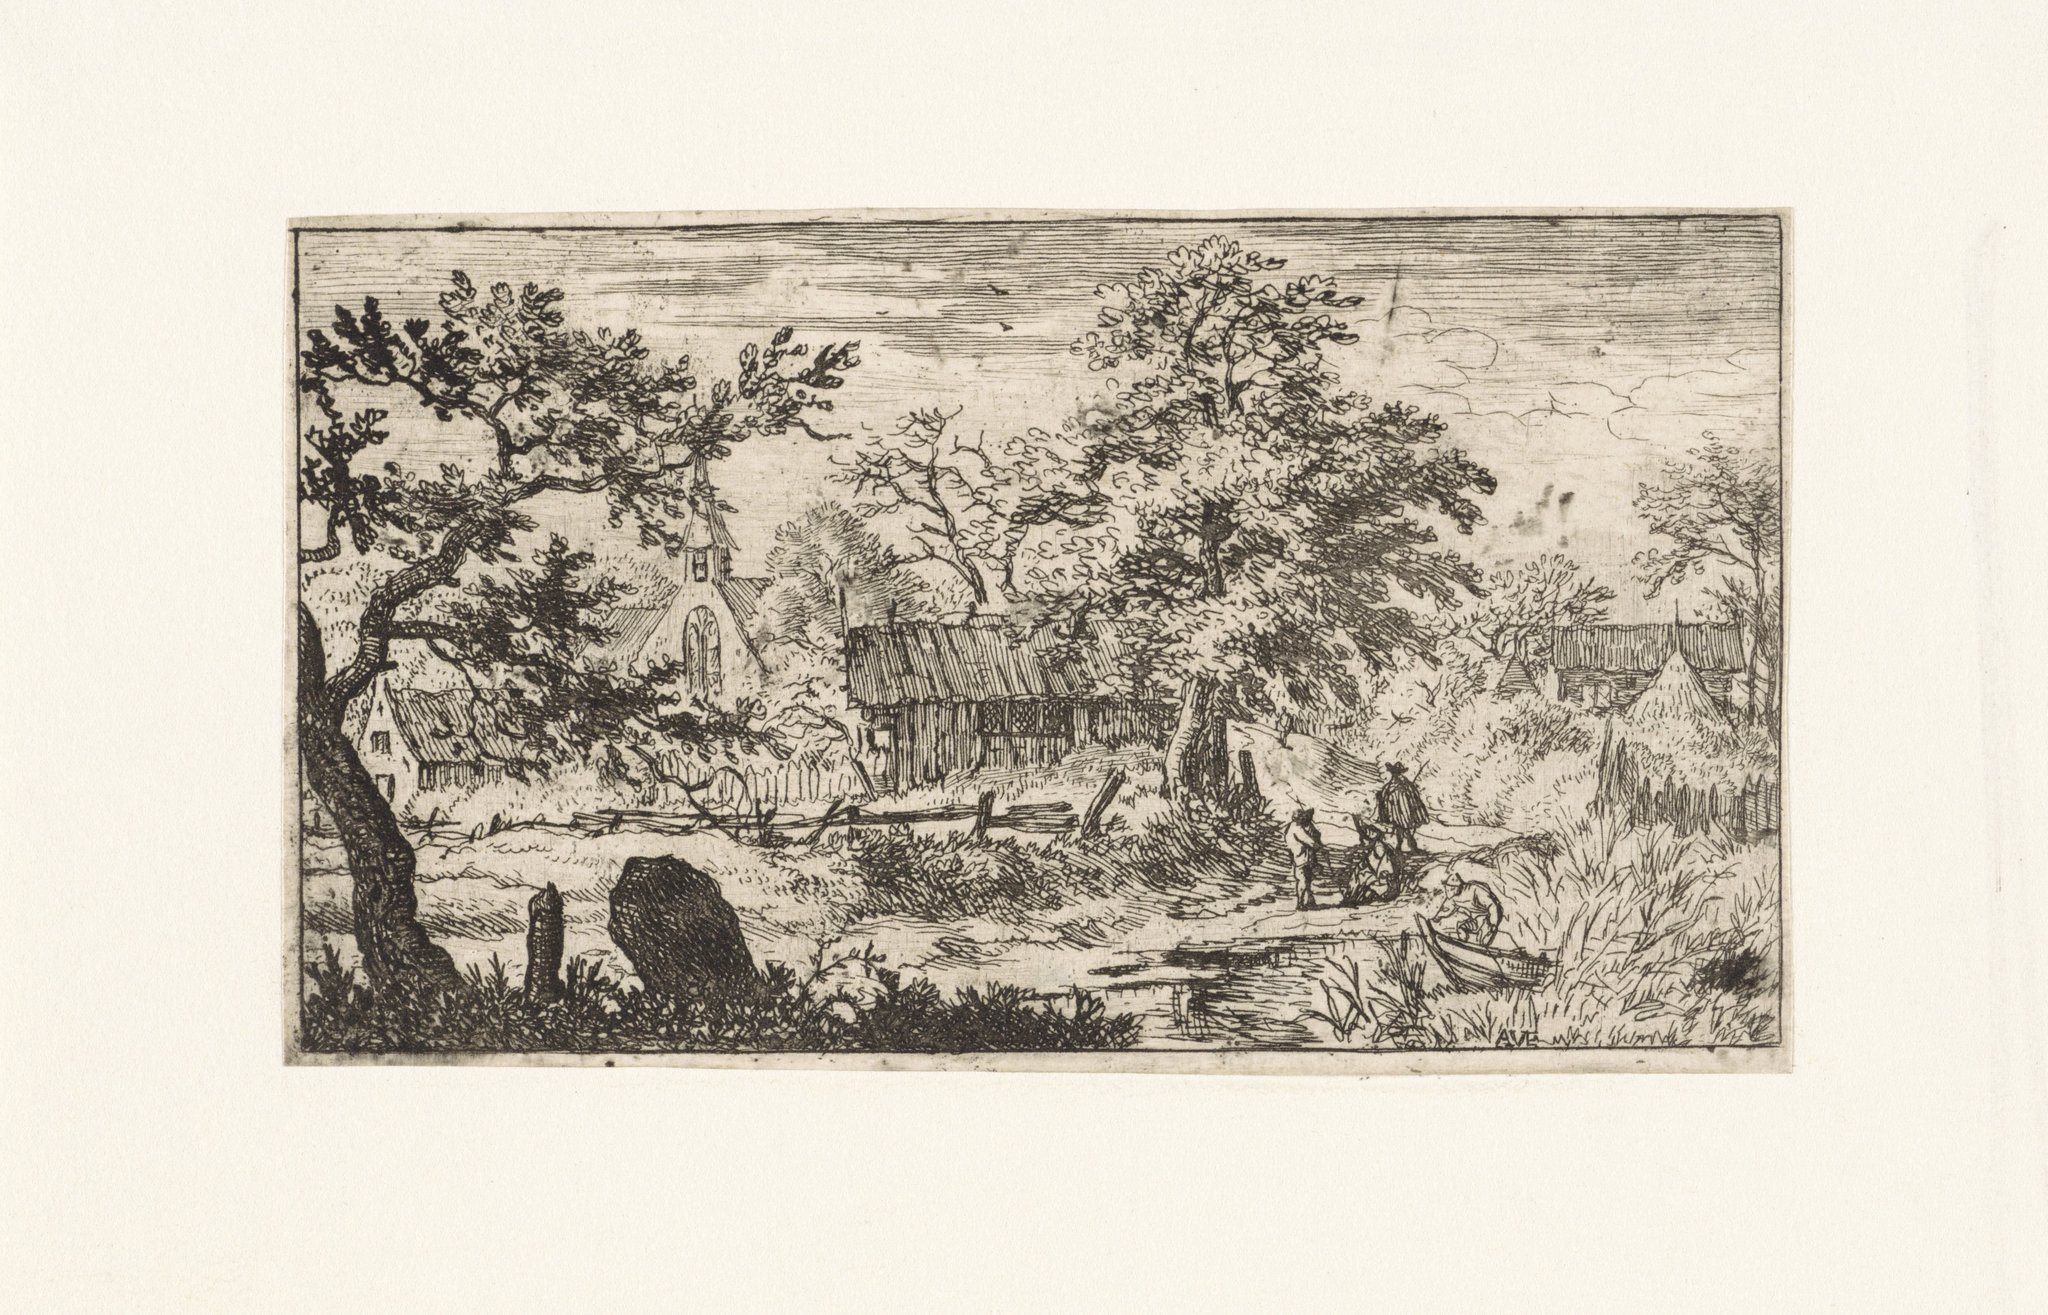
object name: print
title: Landschap met roeiboot in het riet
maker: allaert van everdingen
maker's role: draughtsman, painter, print maker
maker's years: 1621-1675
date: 1631-1675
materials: paper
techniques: etching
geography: netherlands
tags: village (+ city(-scape) with figures, staffage)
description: Gezicht op enkele huizen en een kerk achter twee grote bomen. Tussen het riet een man in een roeiboot en op de oever drie personen.